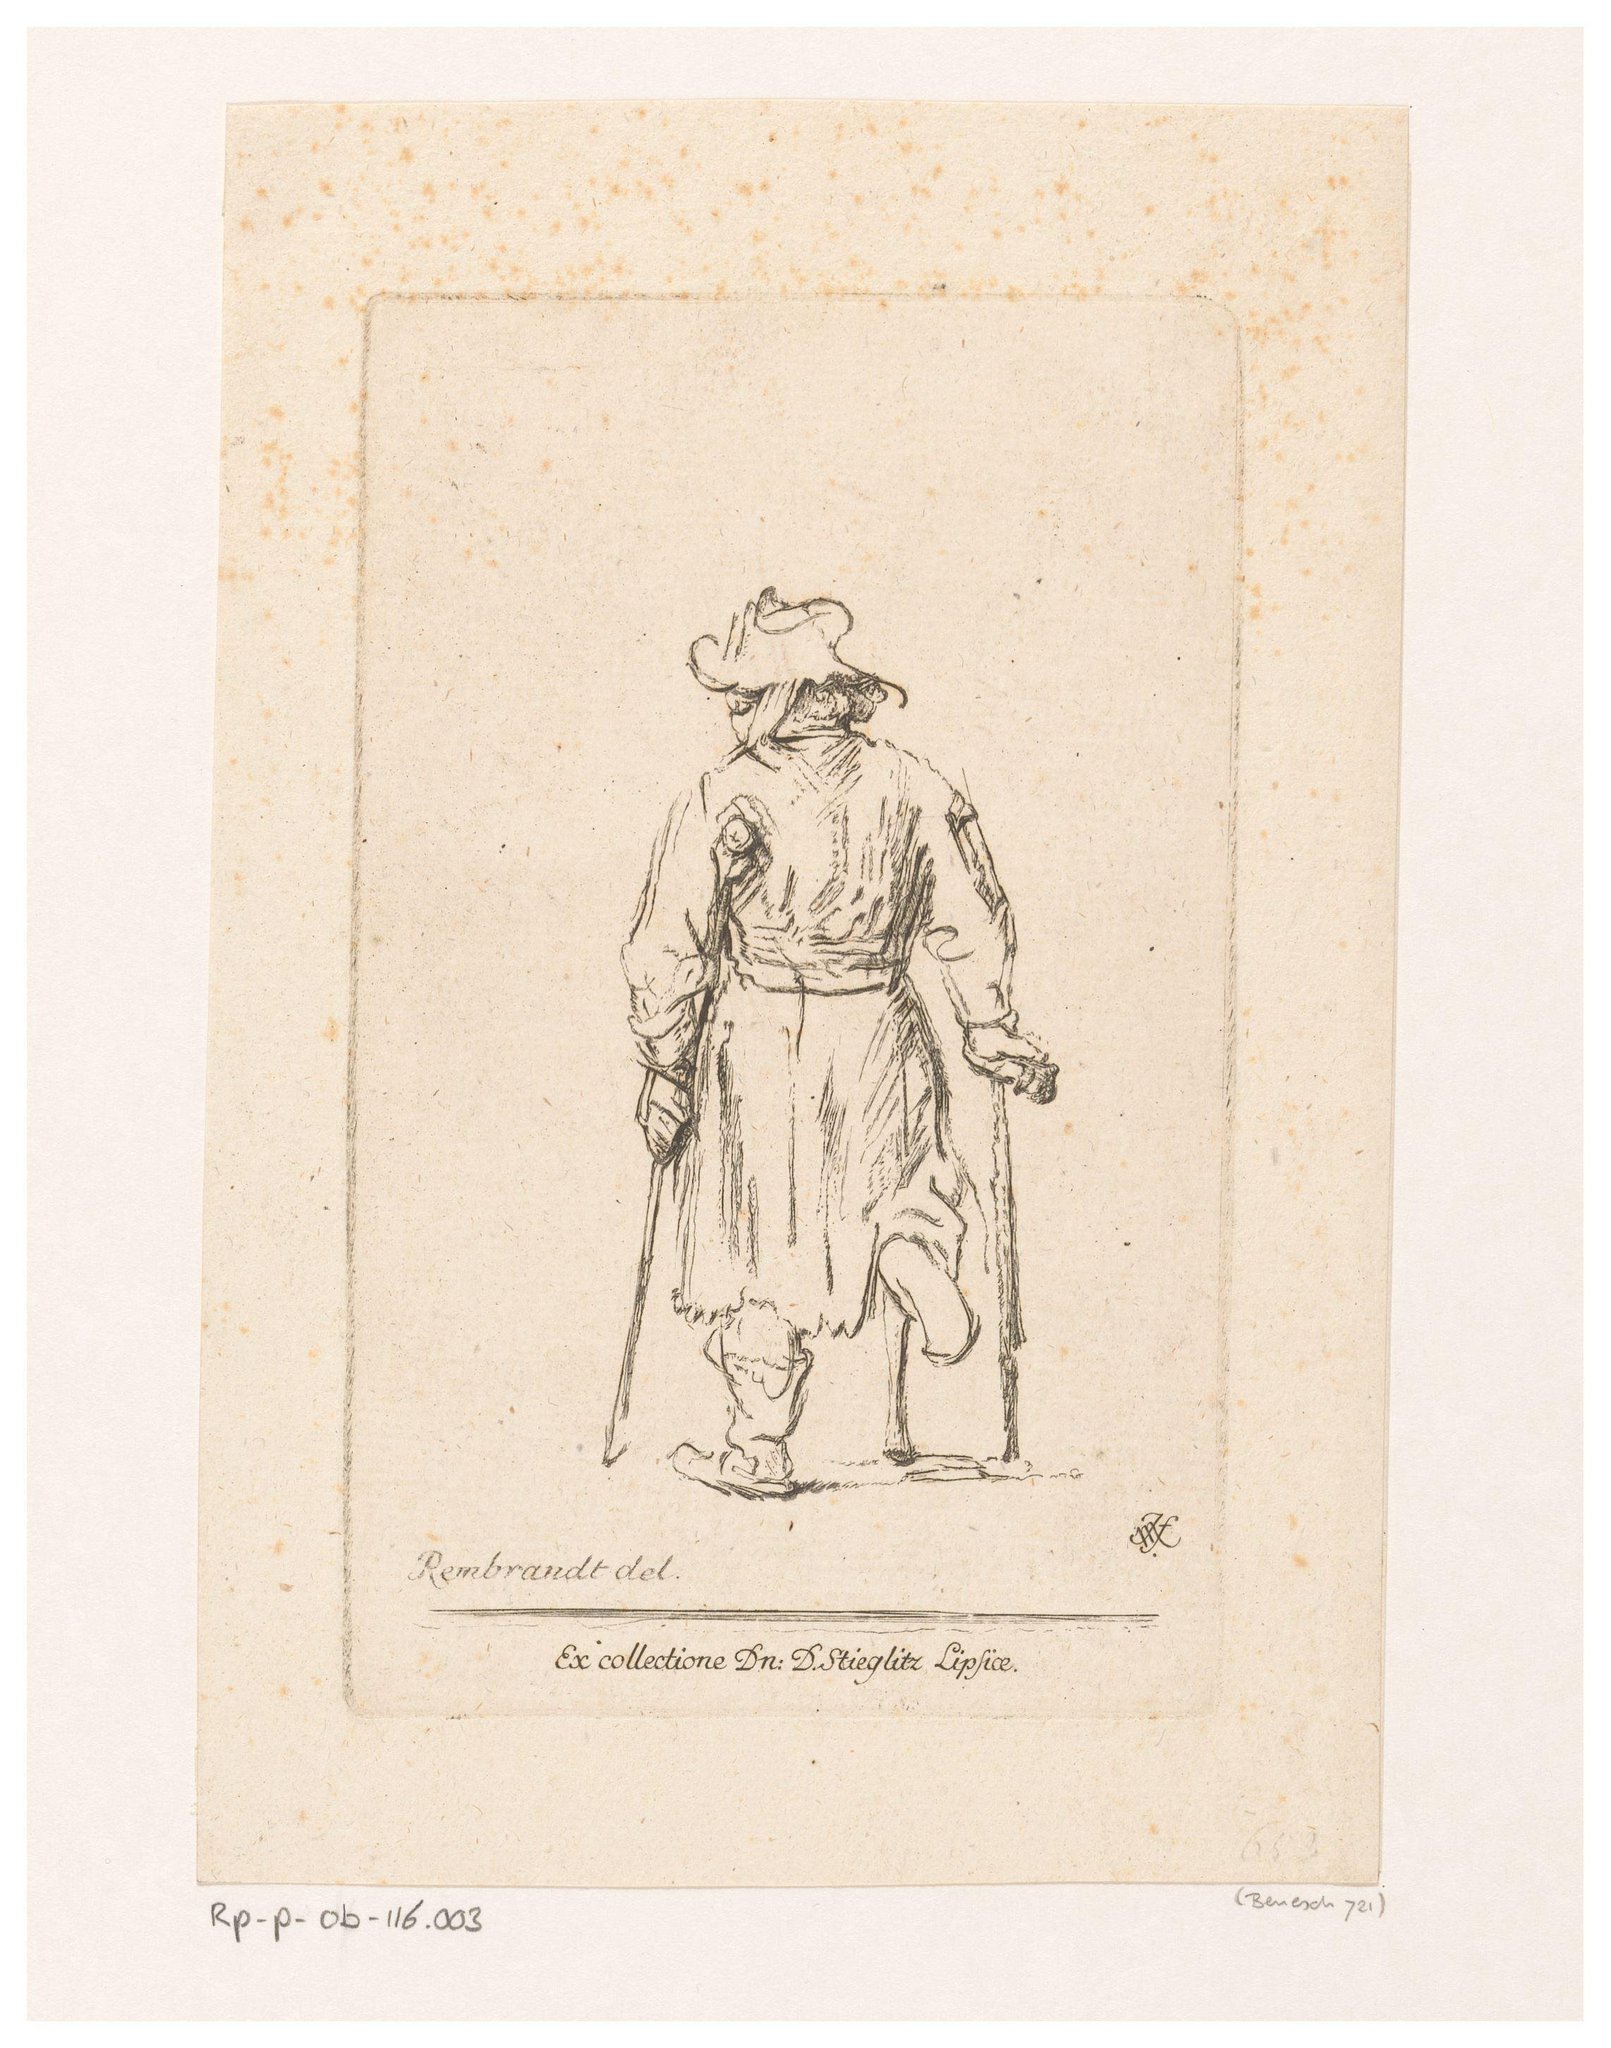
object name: print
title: Man op krukken gezien van de achterzijde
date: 1719-1782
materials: paper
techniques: etching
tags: crutches, wooden leg, person with a physical disability, adult man (+ back view)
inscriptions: collector's mark: Lugt 240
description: Uit de collectie van D. Stieglitz in Leipzig.